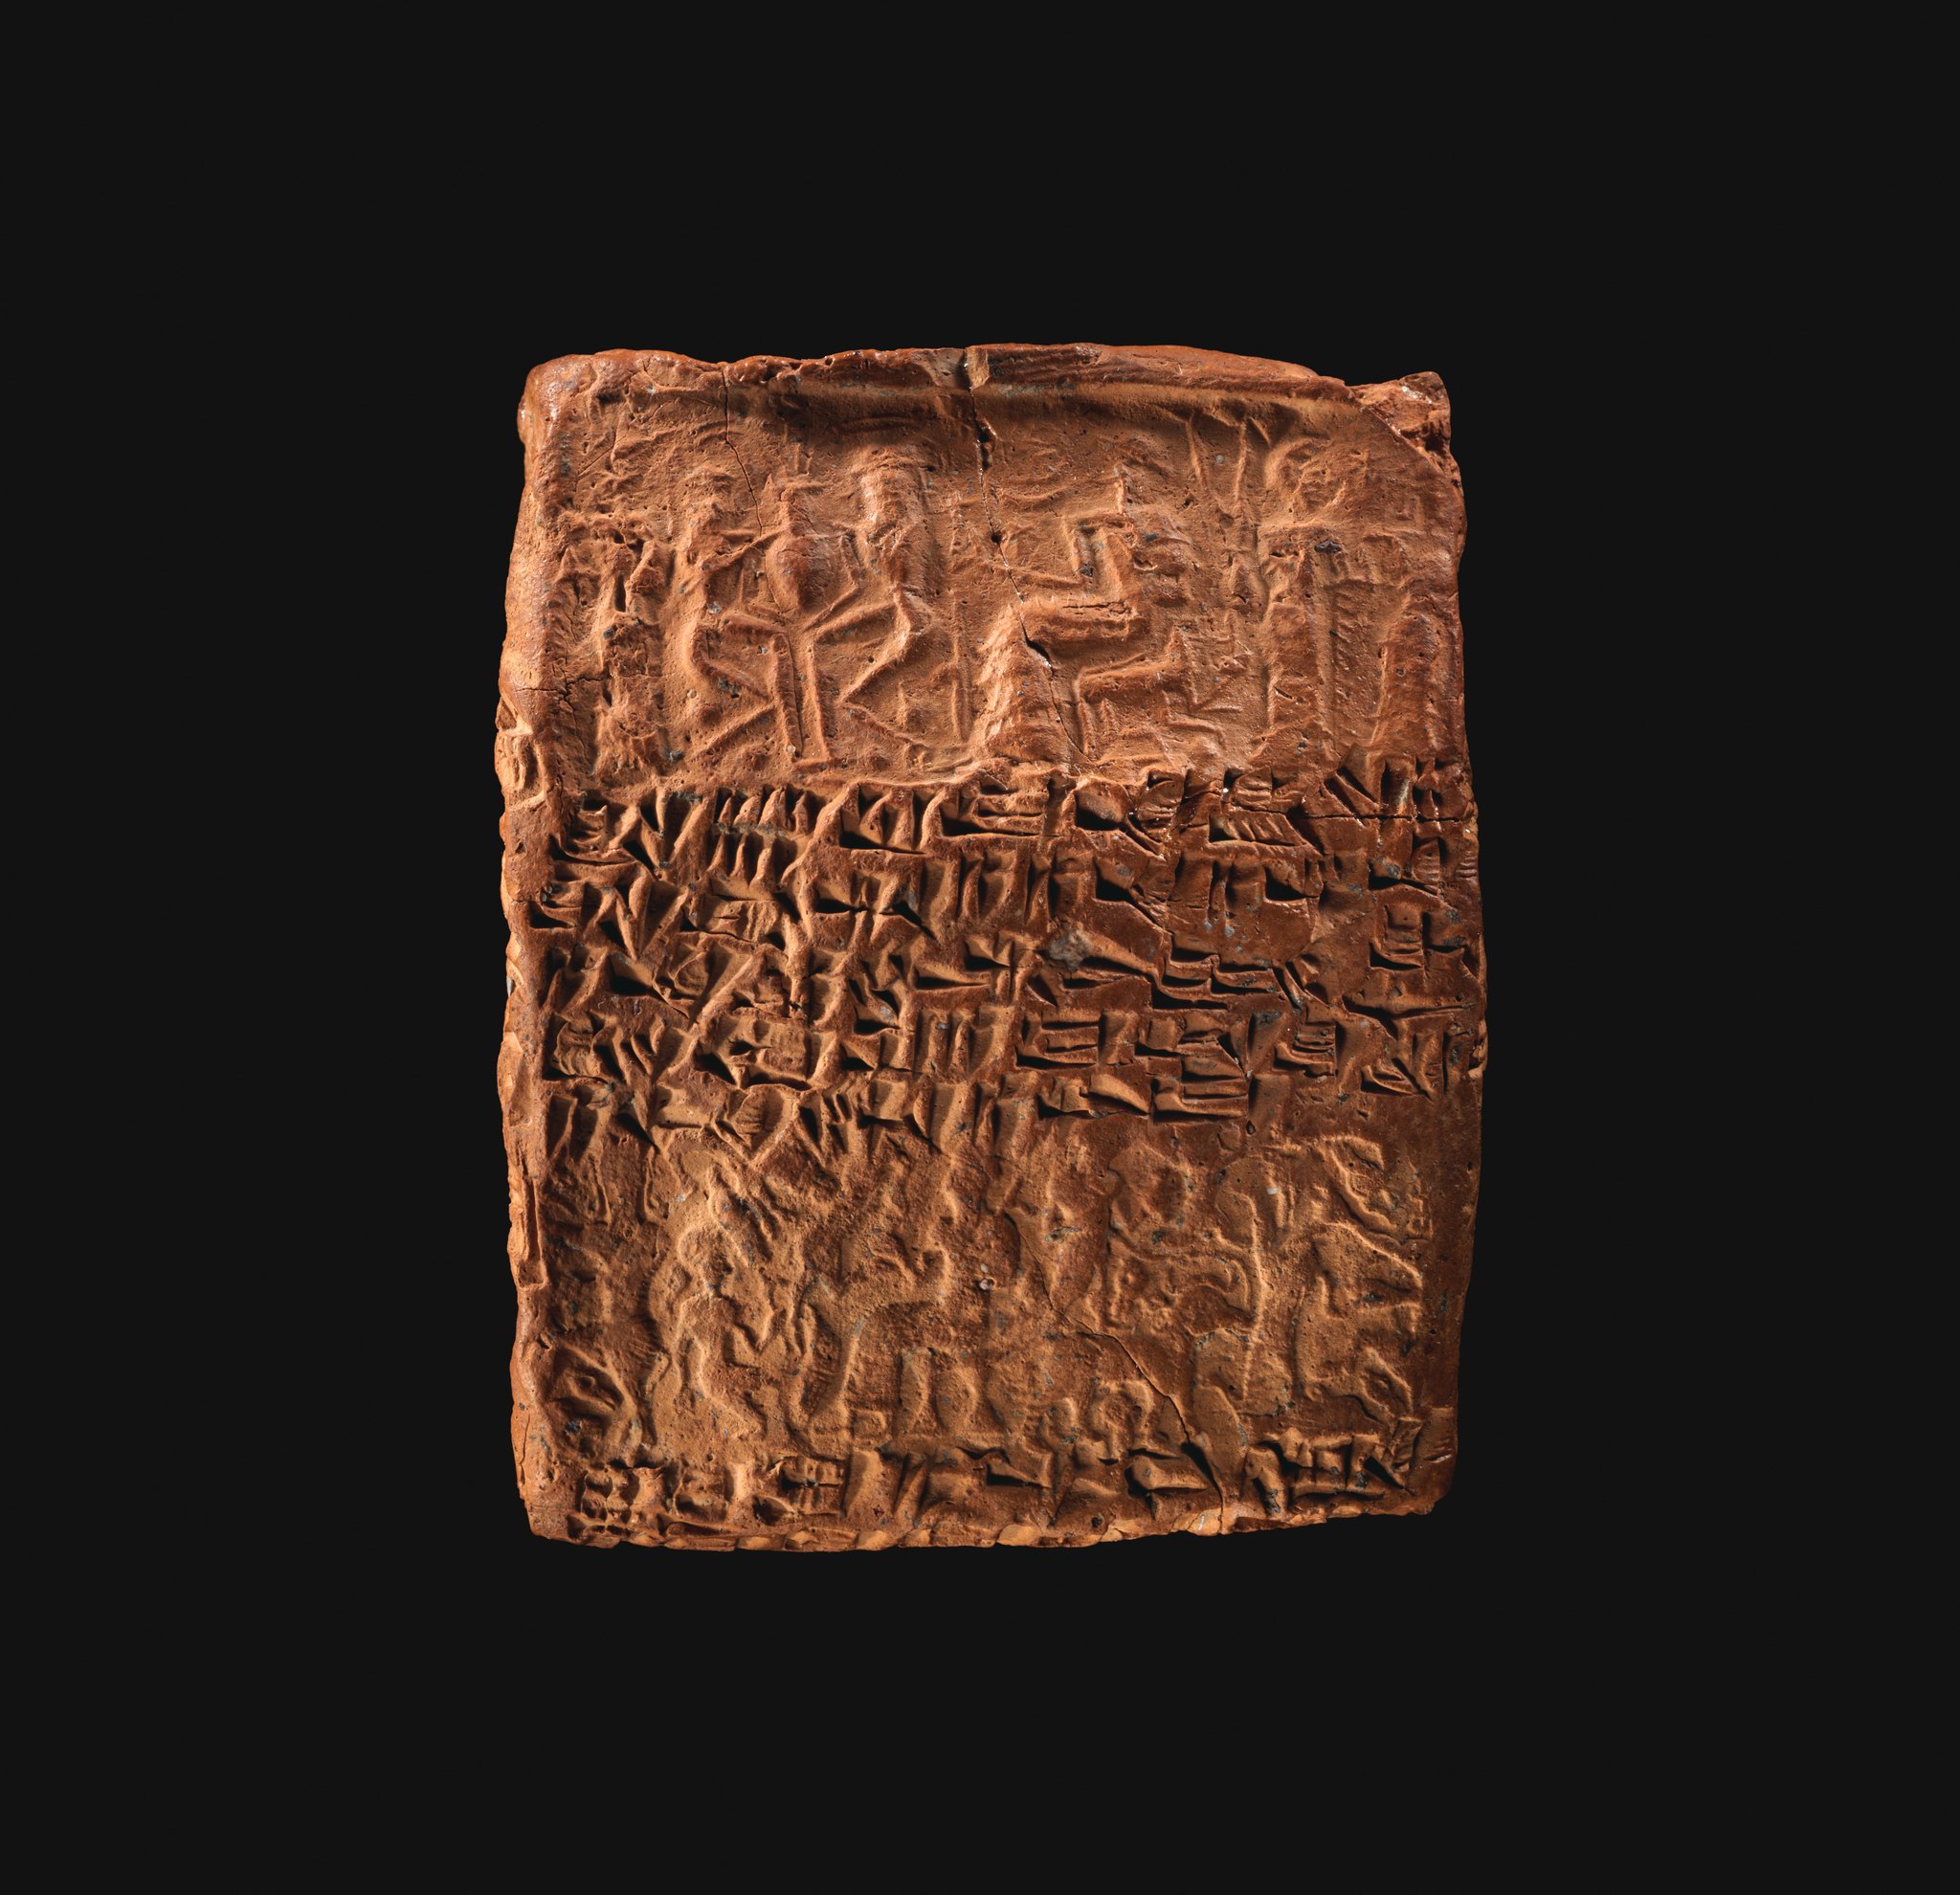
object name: cuneiform tablet case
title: Cuneiform tablet case impressed with four cylinder seals, for cuneiform tablet 66.245.15a: quittance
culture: assyrian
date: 2000-1801 BCE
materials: clay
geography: anatolia